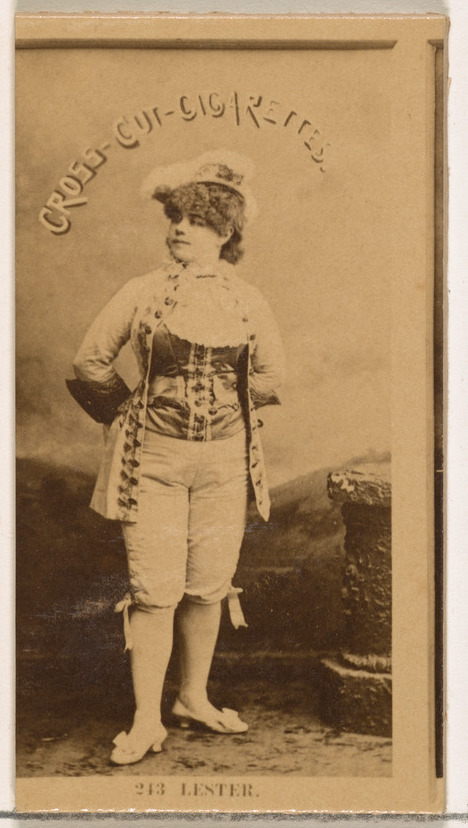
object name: print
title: Card Number 243, Lester, from the Actors and Actresses series (N145-2) issued by Duke Sons & Co. to promote Cross Cut Cigarettes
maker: w. duke, sons & co.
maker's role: publisher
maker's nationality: american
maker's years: 1870-1920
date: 1880-1889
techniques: albumen silver print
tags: portraits,women,actresses